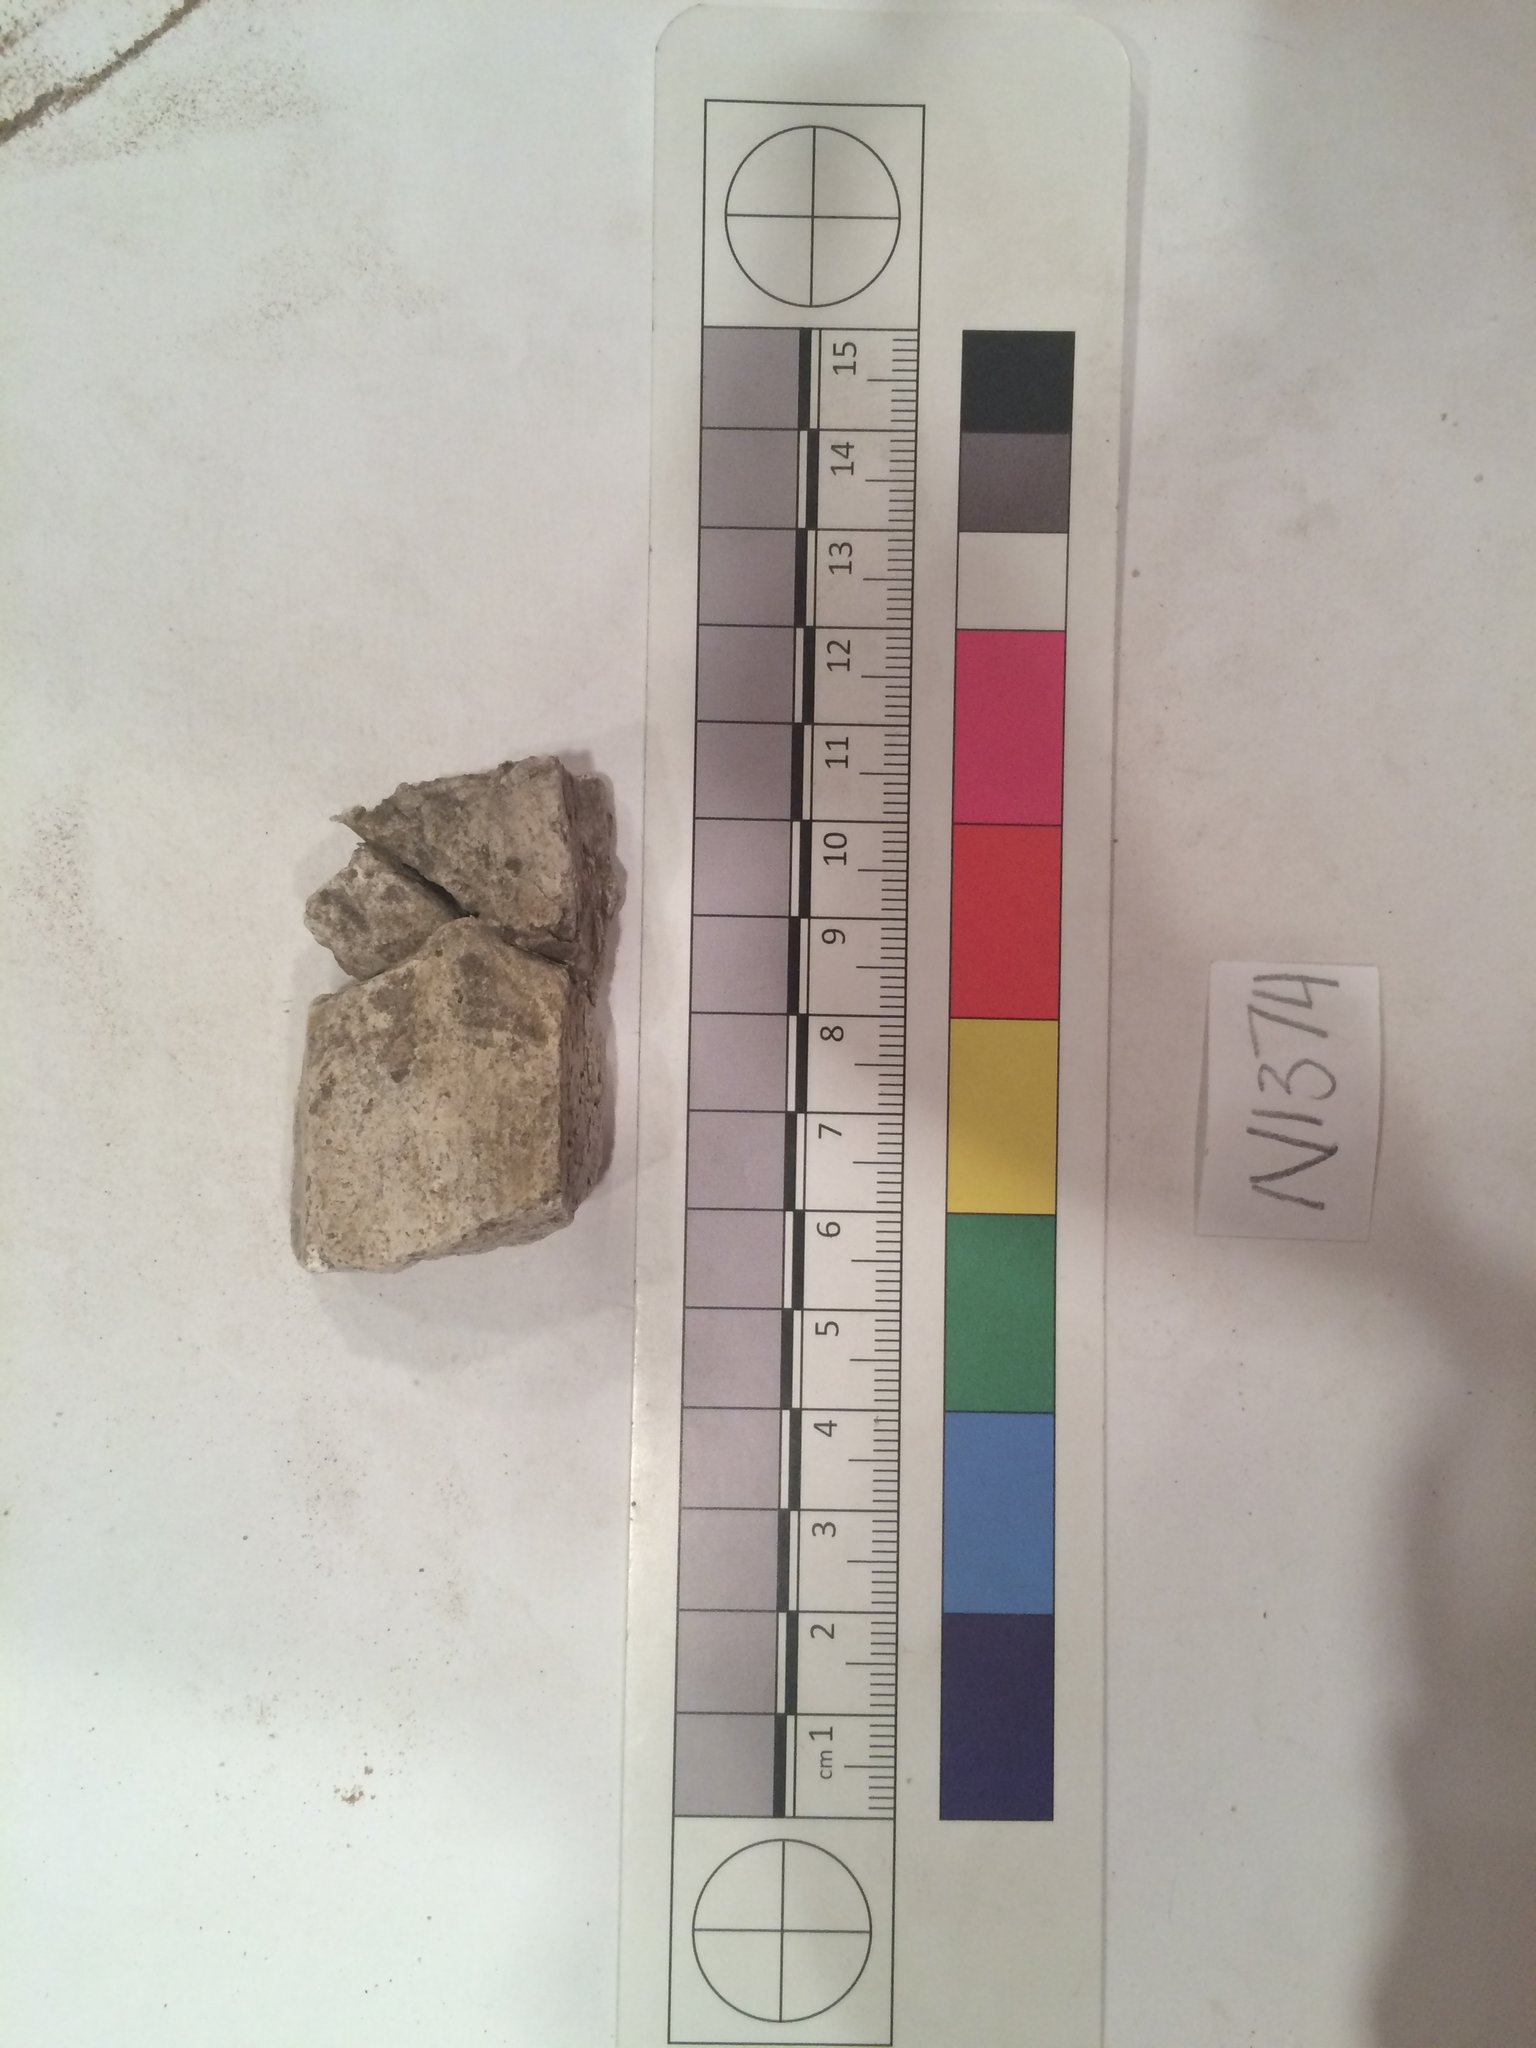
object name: fragment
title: Stucco Fragment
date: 701-1200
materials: plaster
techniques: carving, painting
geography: iran